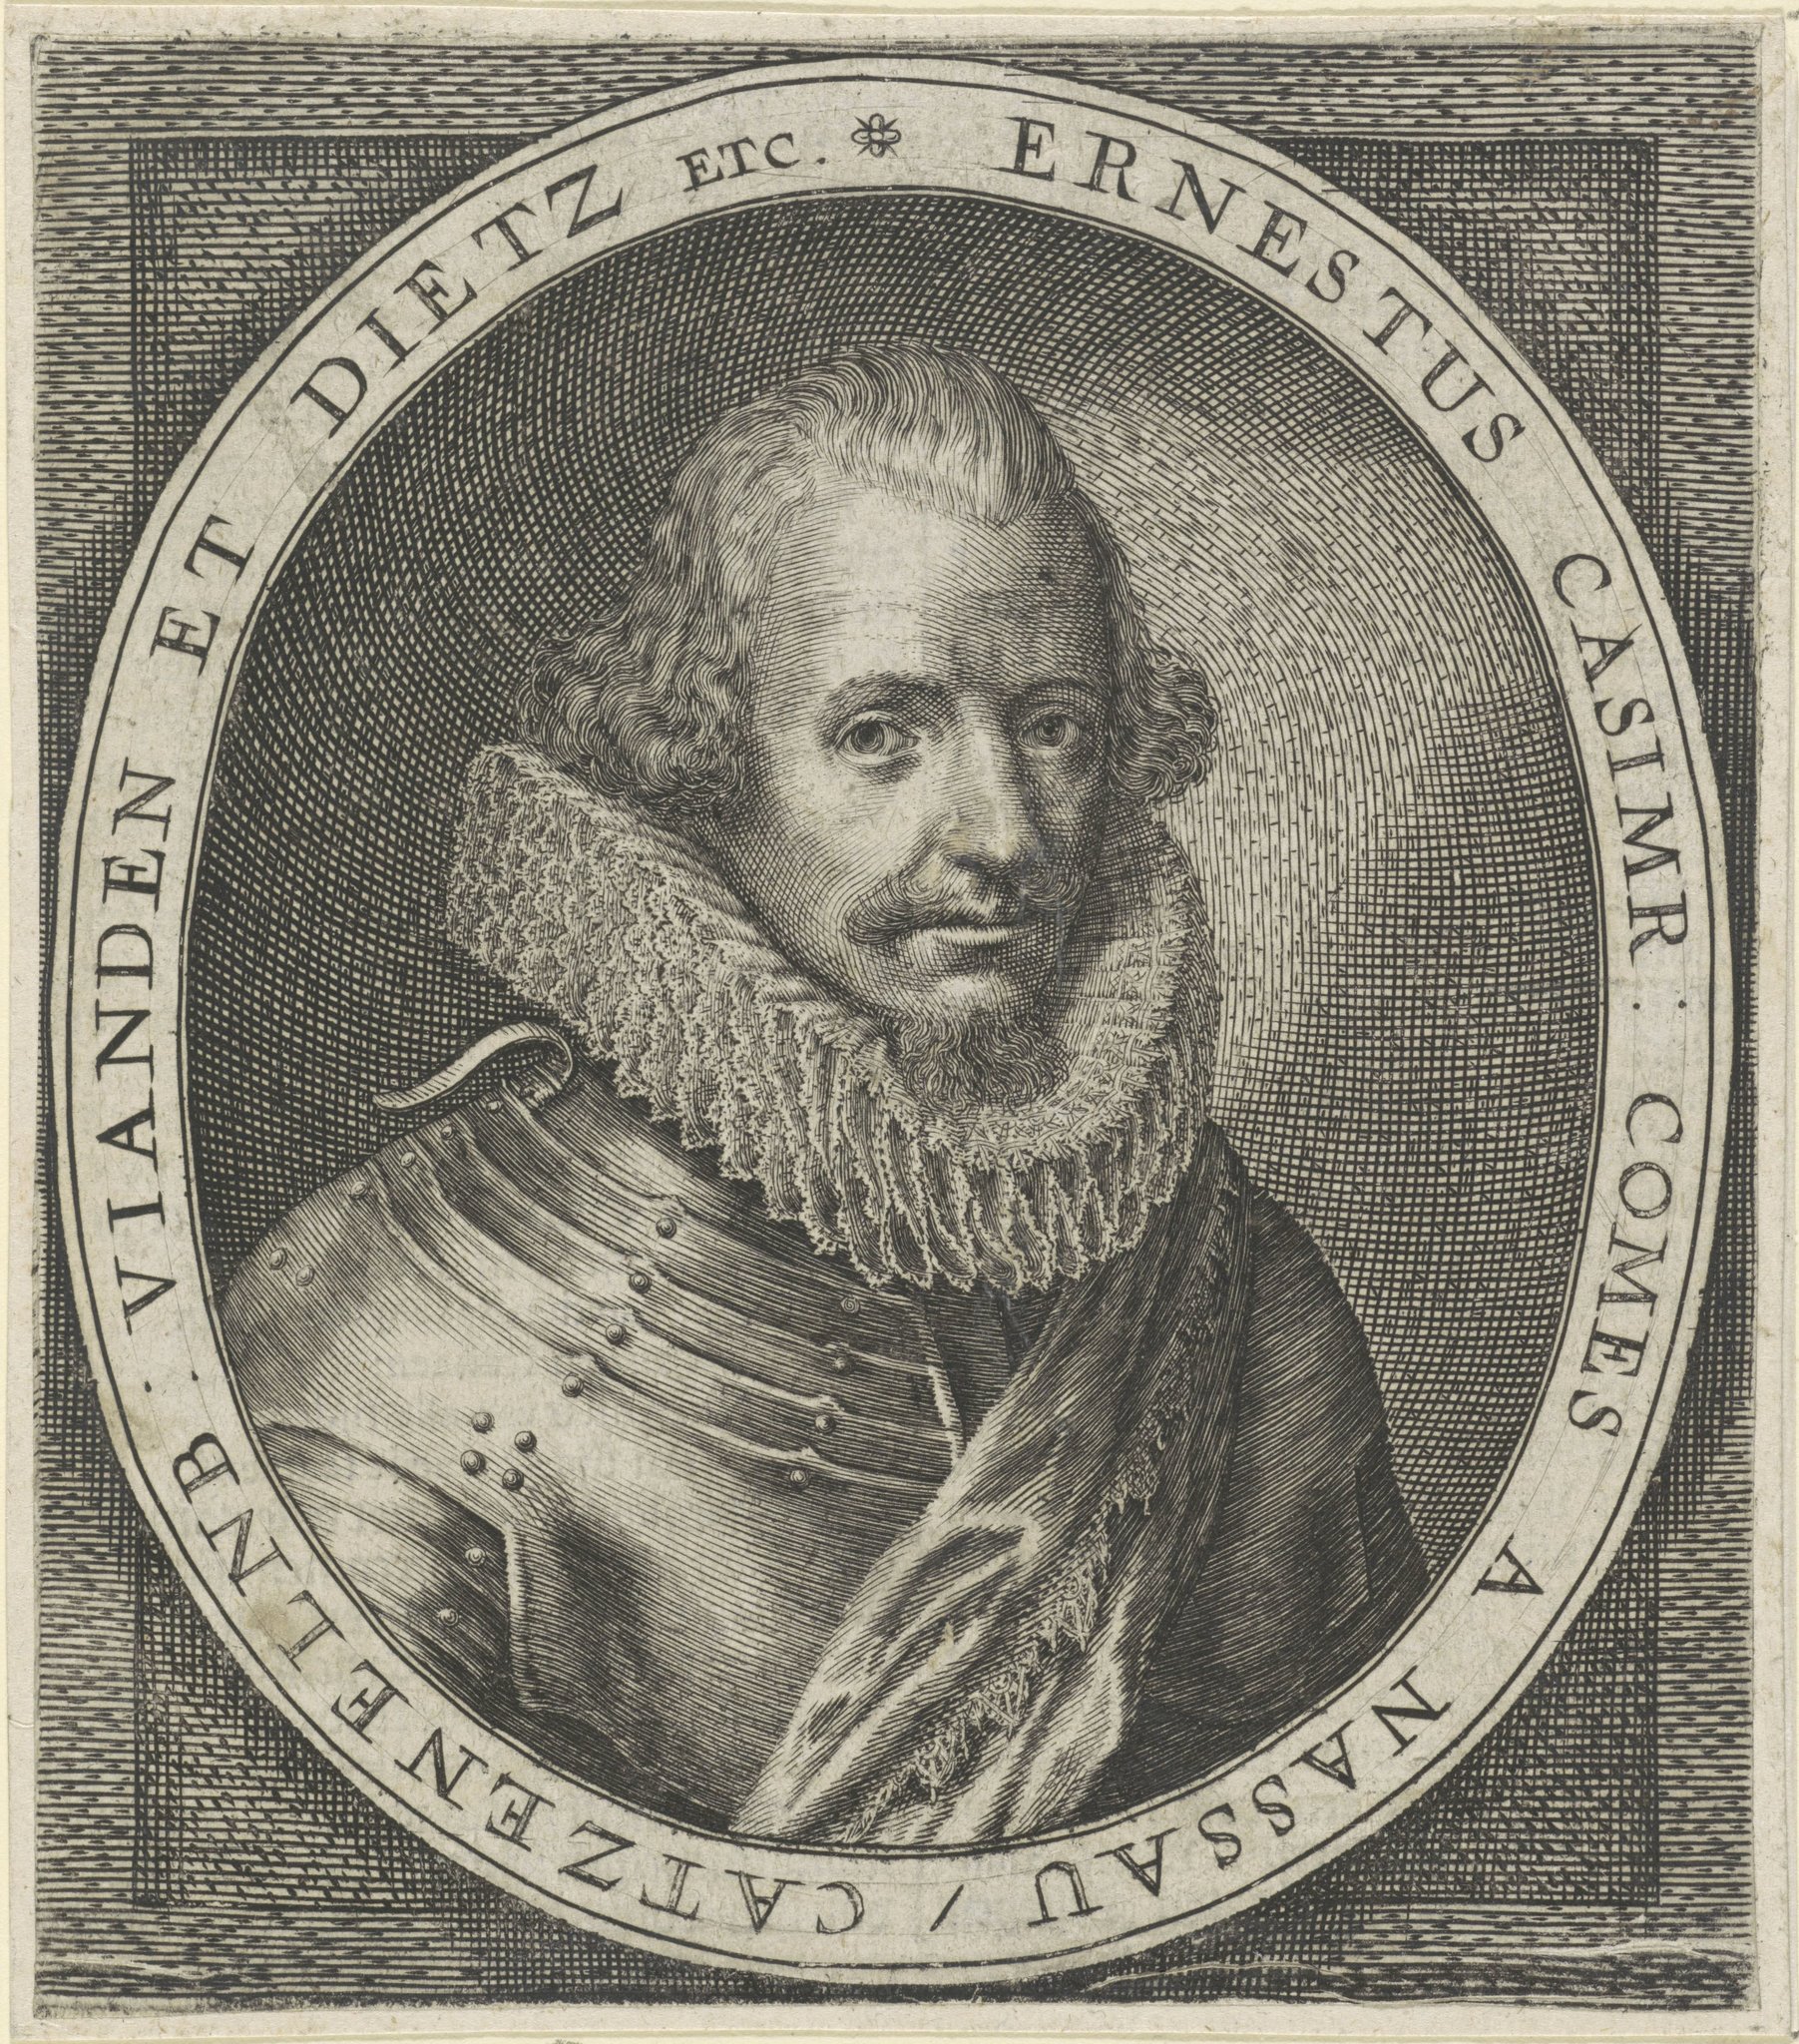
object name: print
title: Portret van Ernst Casimir, graaf van Nassau-Dietz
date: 1615-1616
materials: paper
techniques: engraving, etching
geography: amsterdam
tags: ernst casimir graaf van nassau-dietz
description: De hier vermelde titel verwijst naar de hoogst verkregen titel van de geportretteerde, niet per se naar de titel die de geportretteerde op deze voorstelling draagt. Prent uit: Baudartius, Willem. Afbeeldinghe, ende beschrĳvinghe van alle de veld-slagen (...) ghevallen in de Nederlanden, geduerende d'oorloghe teghens den coningh van Spaengien. Amsterdam: Michiel Colijn, 1615-1616.